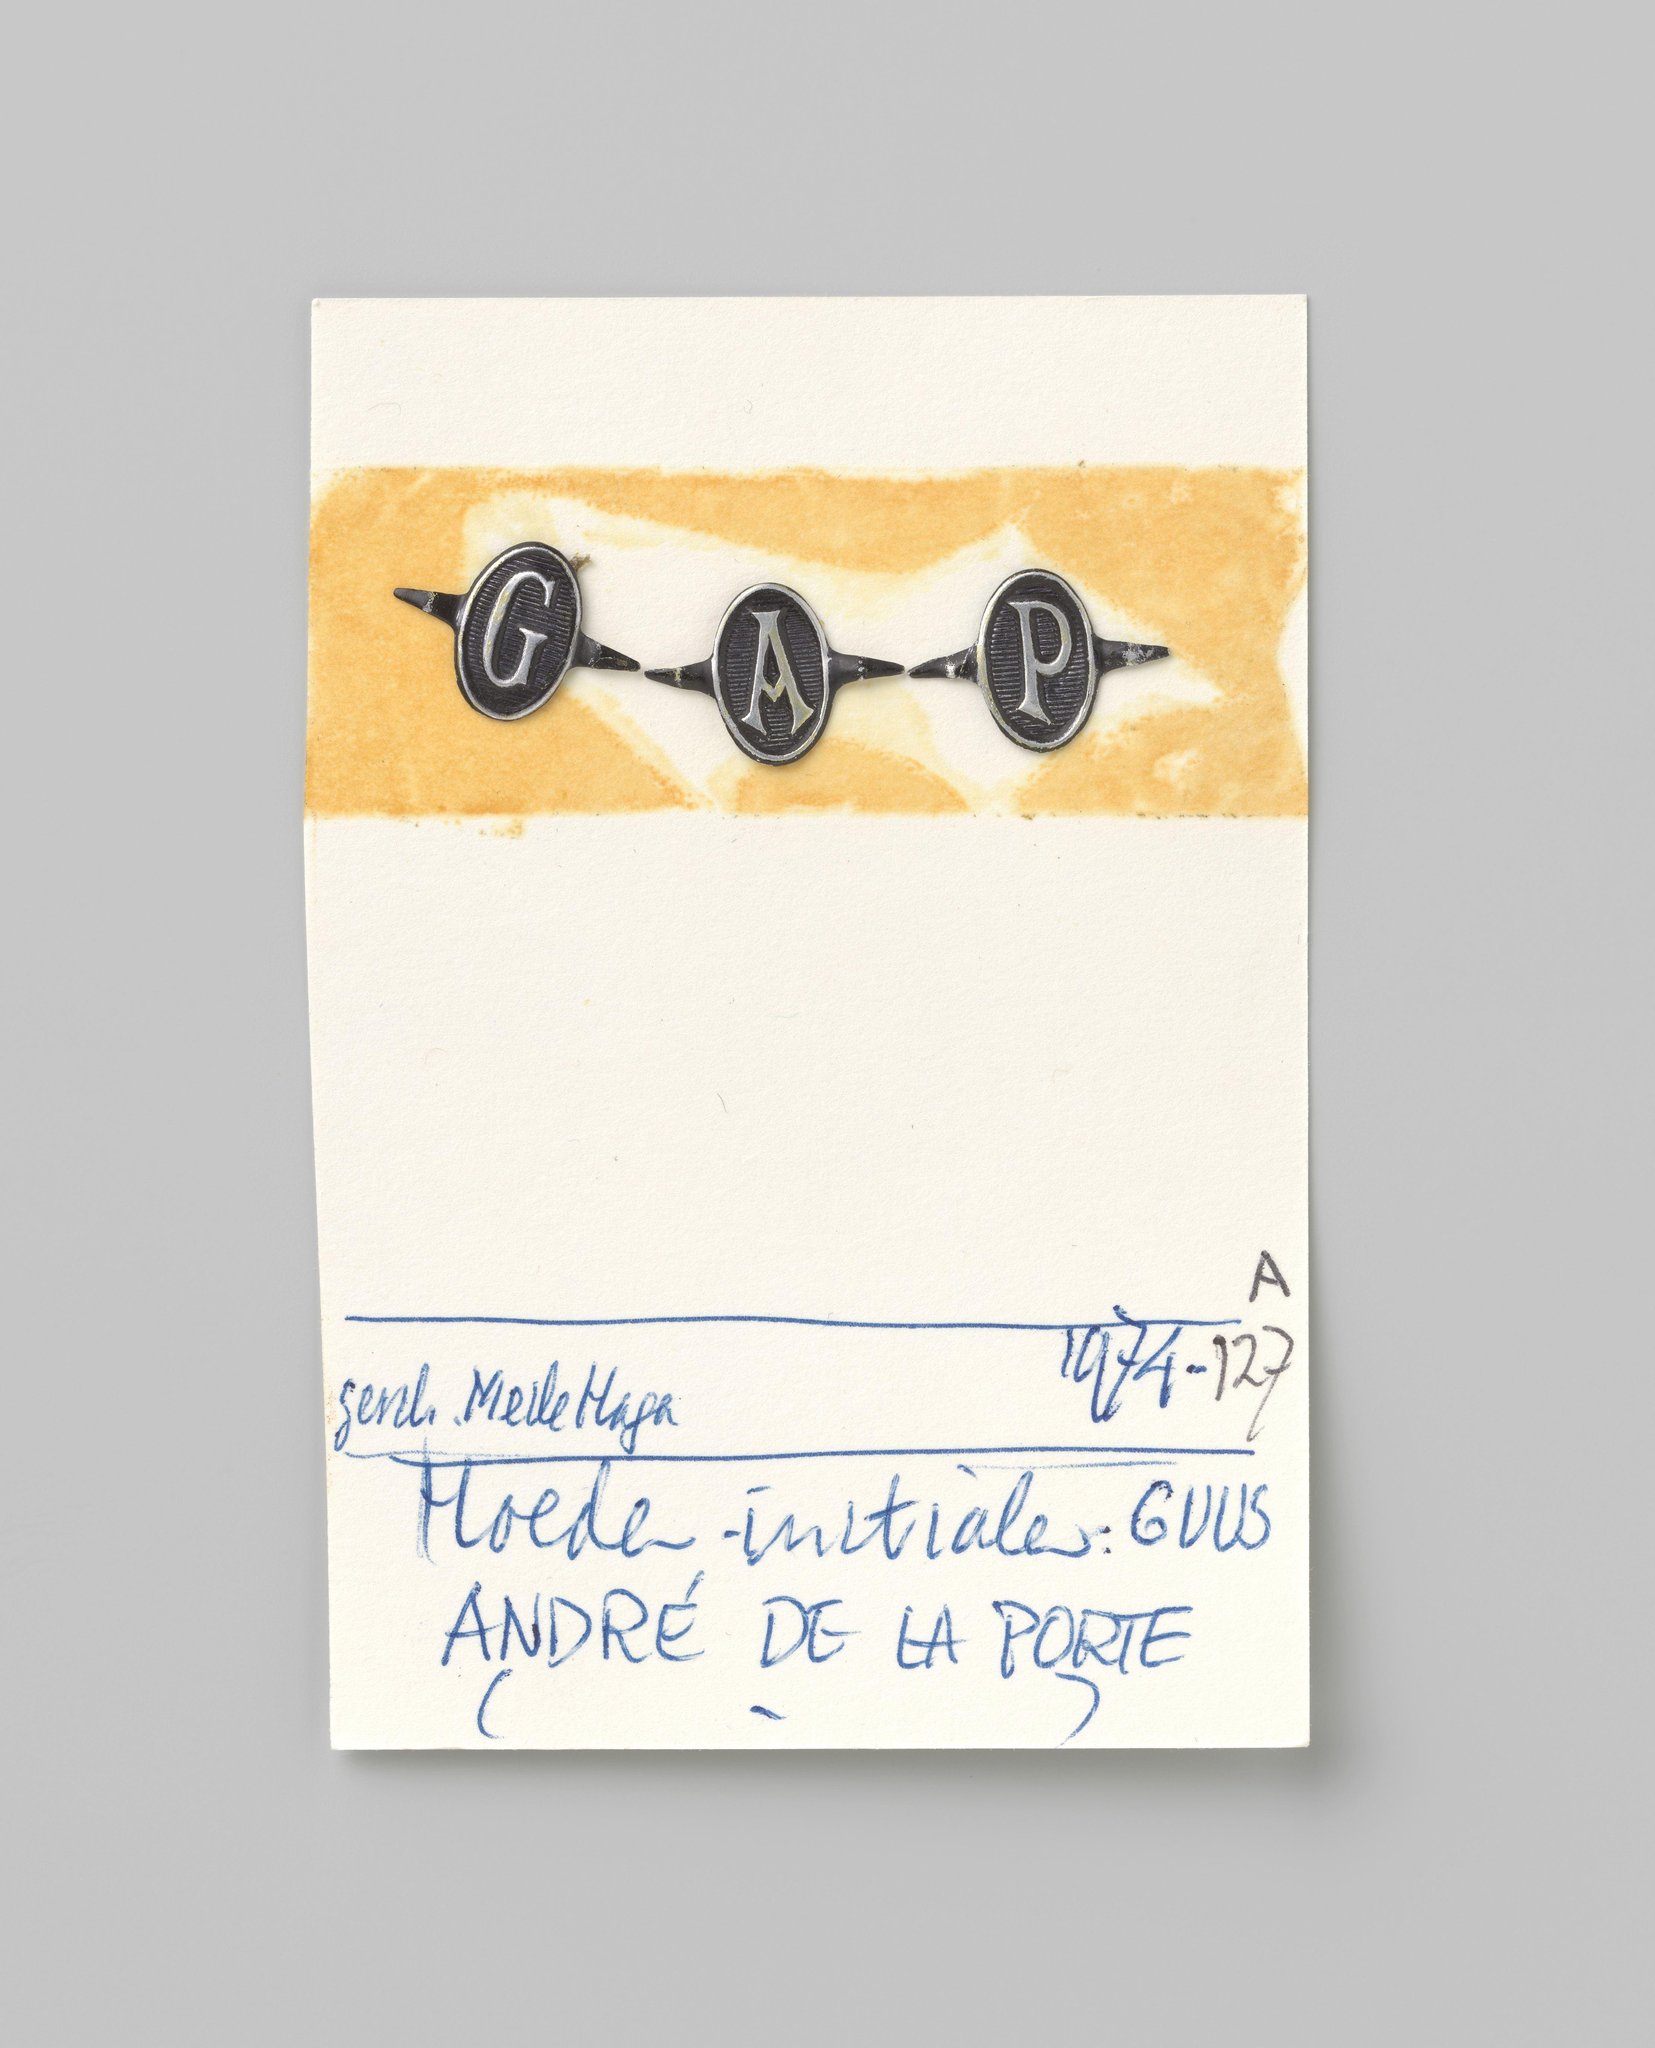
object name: part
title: Letter G om aan hoedenlint te klemmen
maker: Anonymous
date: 1850-1930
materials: metal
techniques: striking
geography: europe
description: De letter hoort bij het drietal letters G A P: Guus André de la Porte.